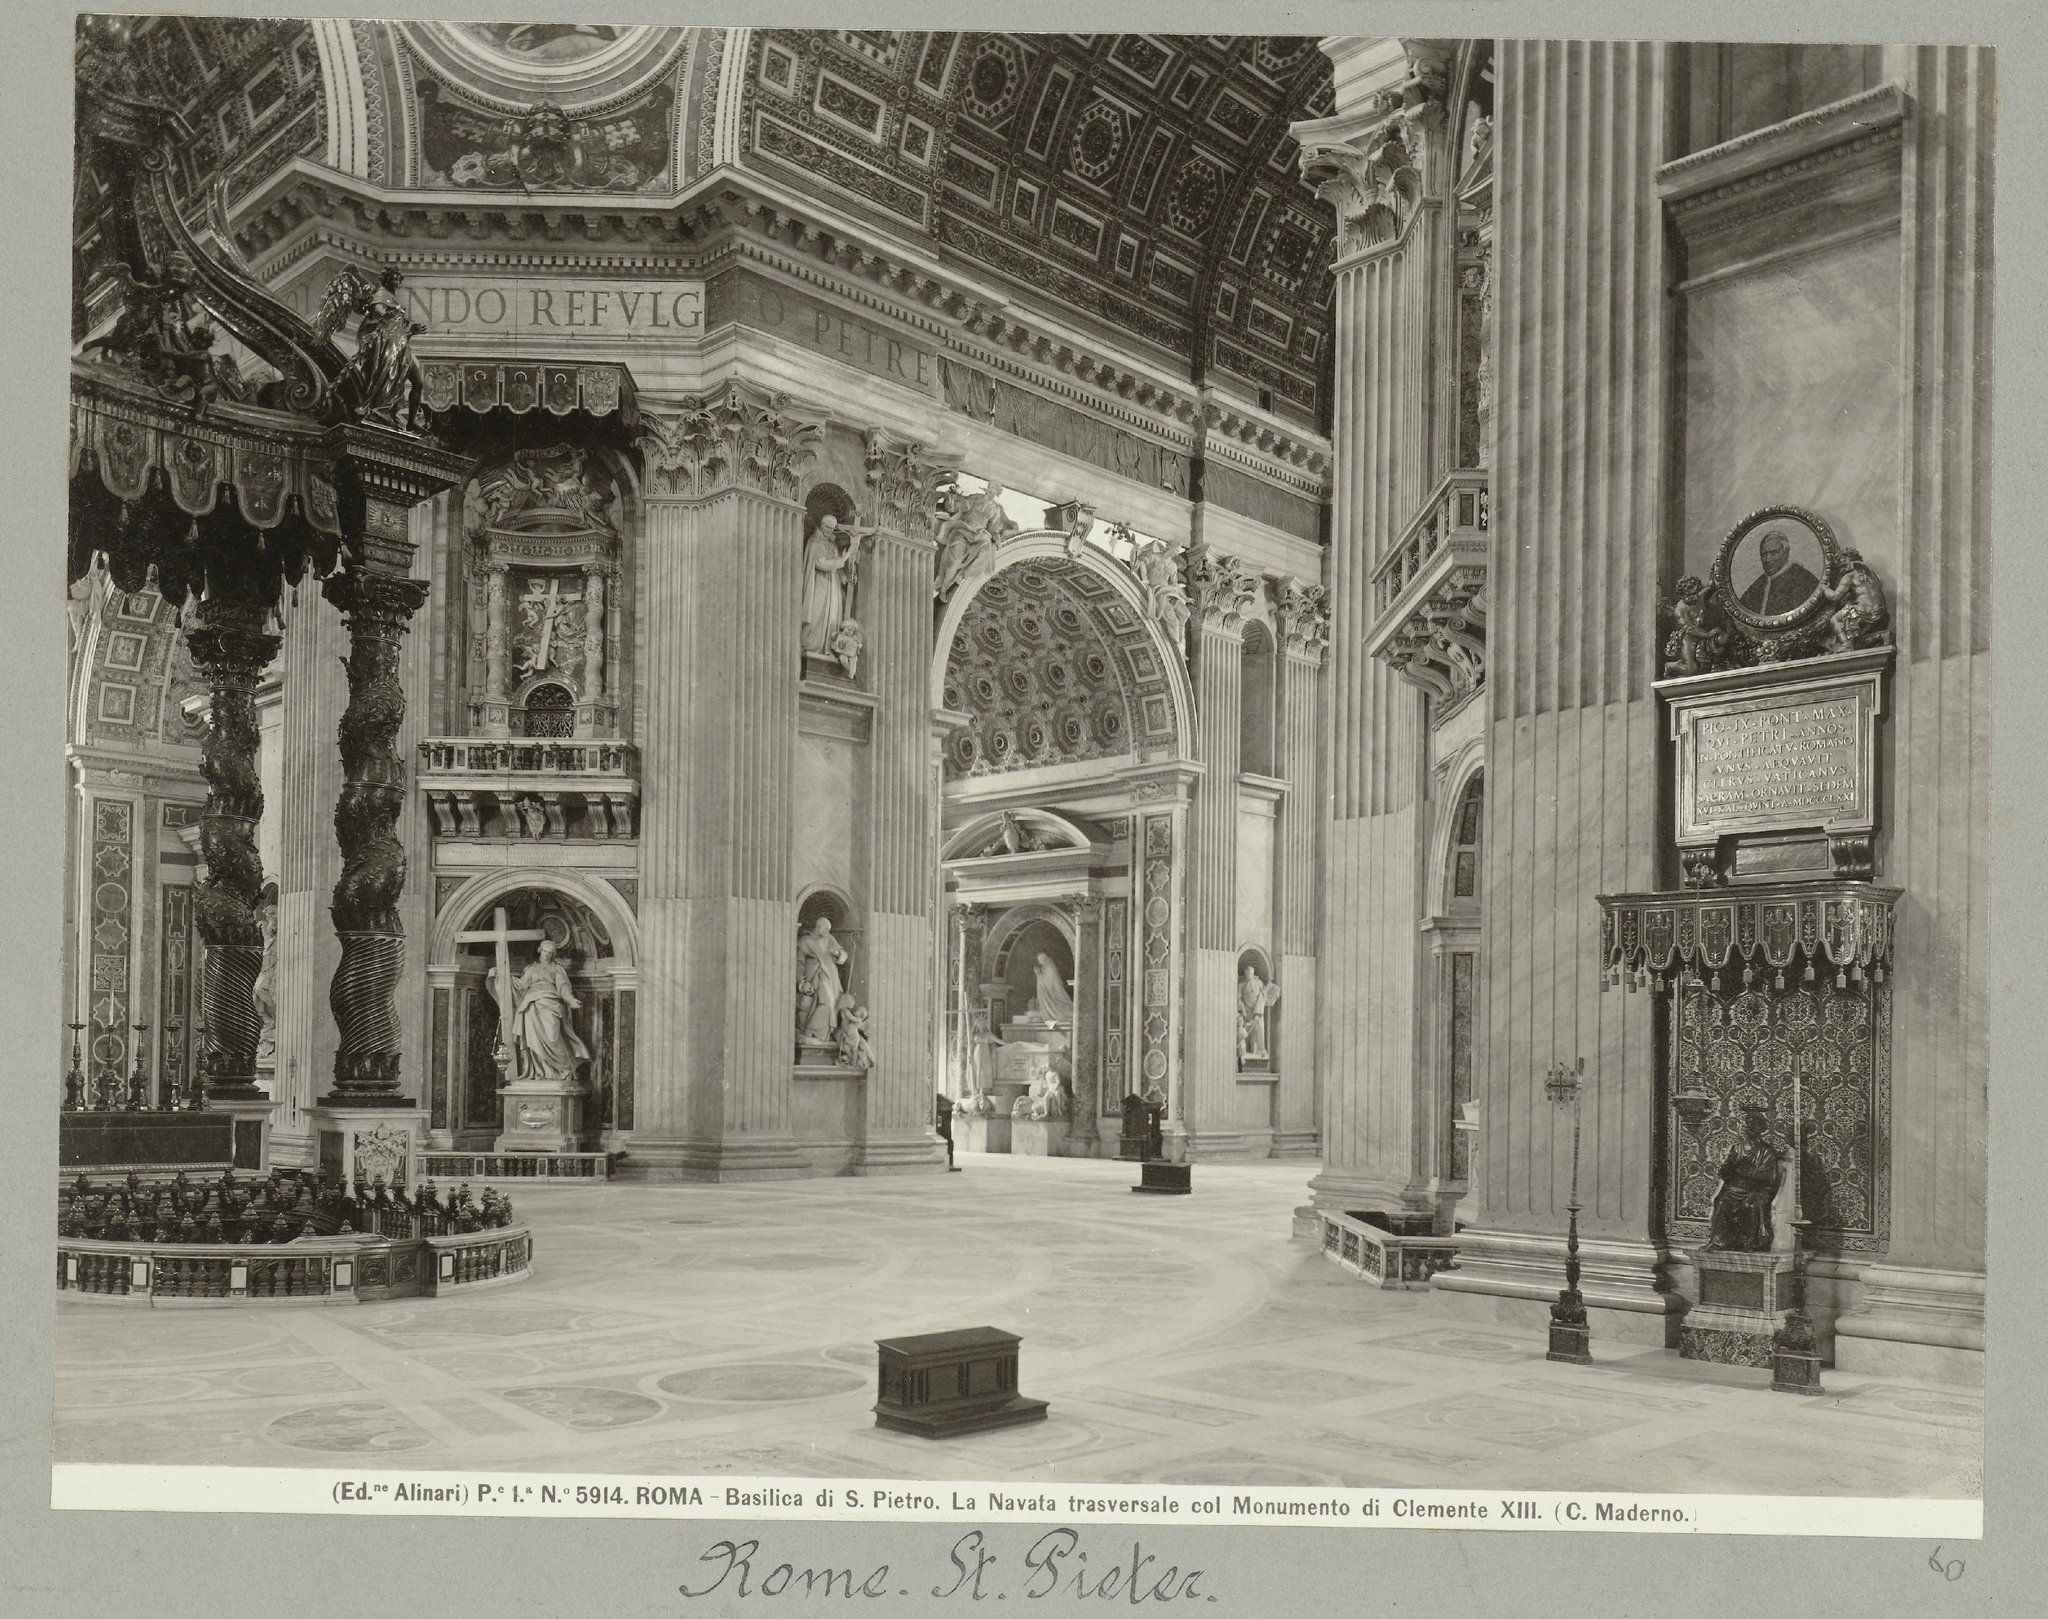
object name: photograph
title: P.I.N.5898 Roma - Basilica di S. Pietro la Navata trasversale col Monumento di Clemente XIII (C. Maderno).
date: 1893-1903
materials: cardboard, photographic support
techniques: albumen print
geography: netherlands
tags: sint-pietersbasiliek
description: Het zijschip van de Sint Pieter met rechts voor het monument voor Clemens XIII